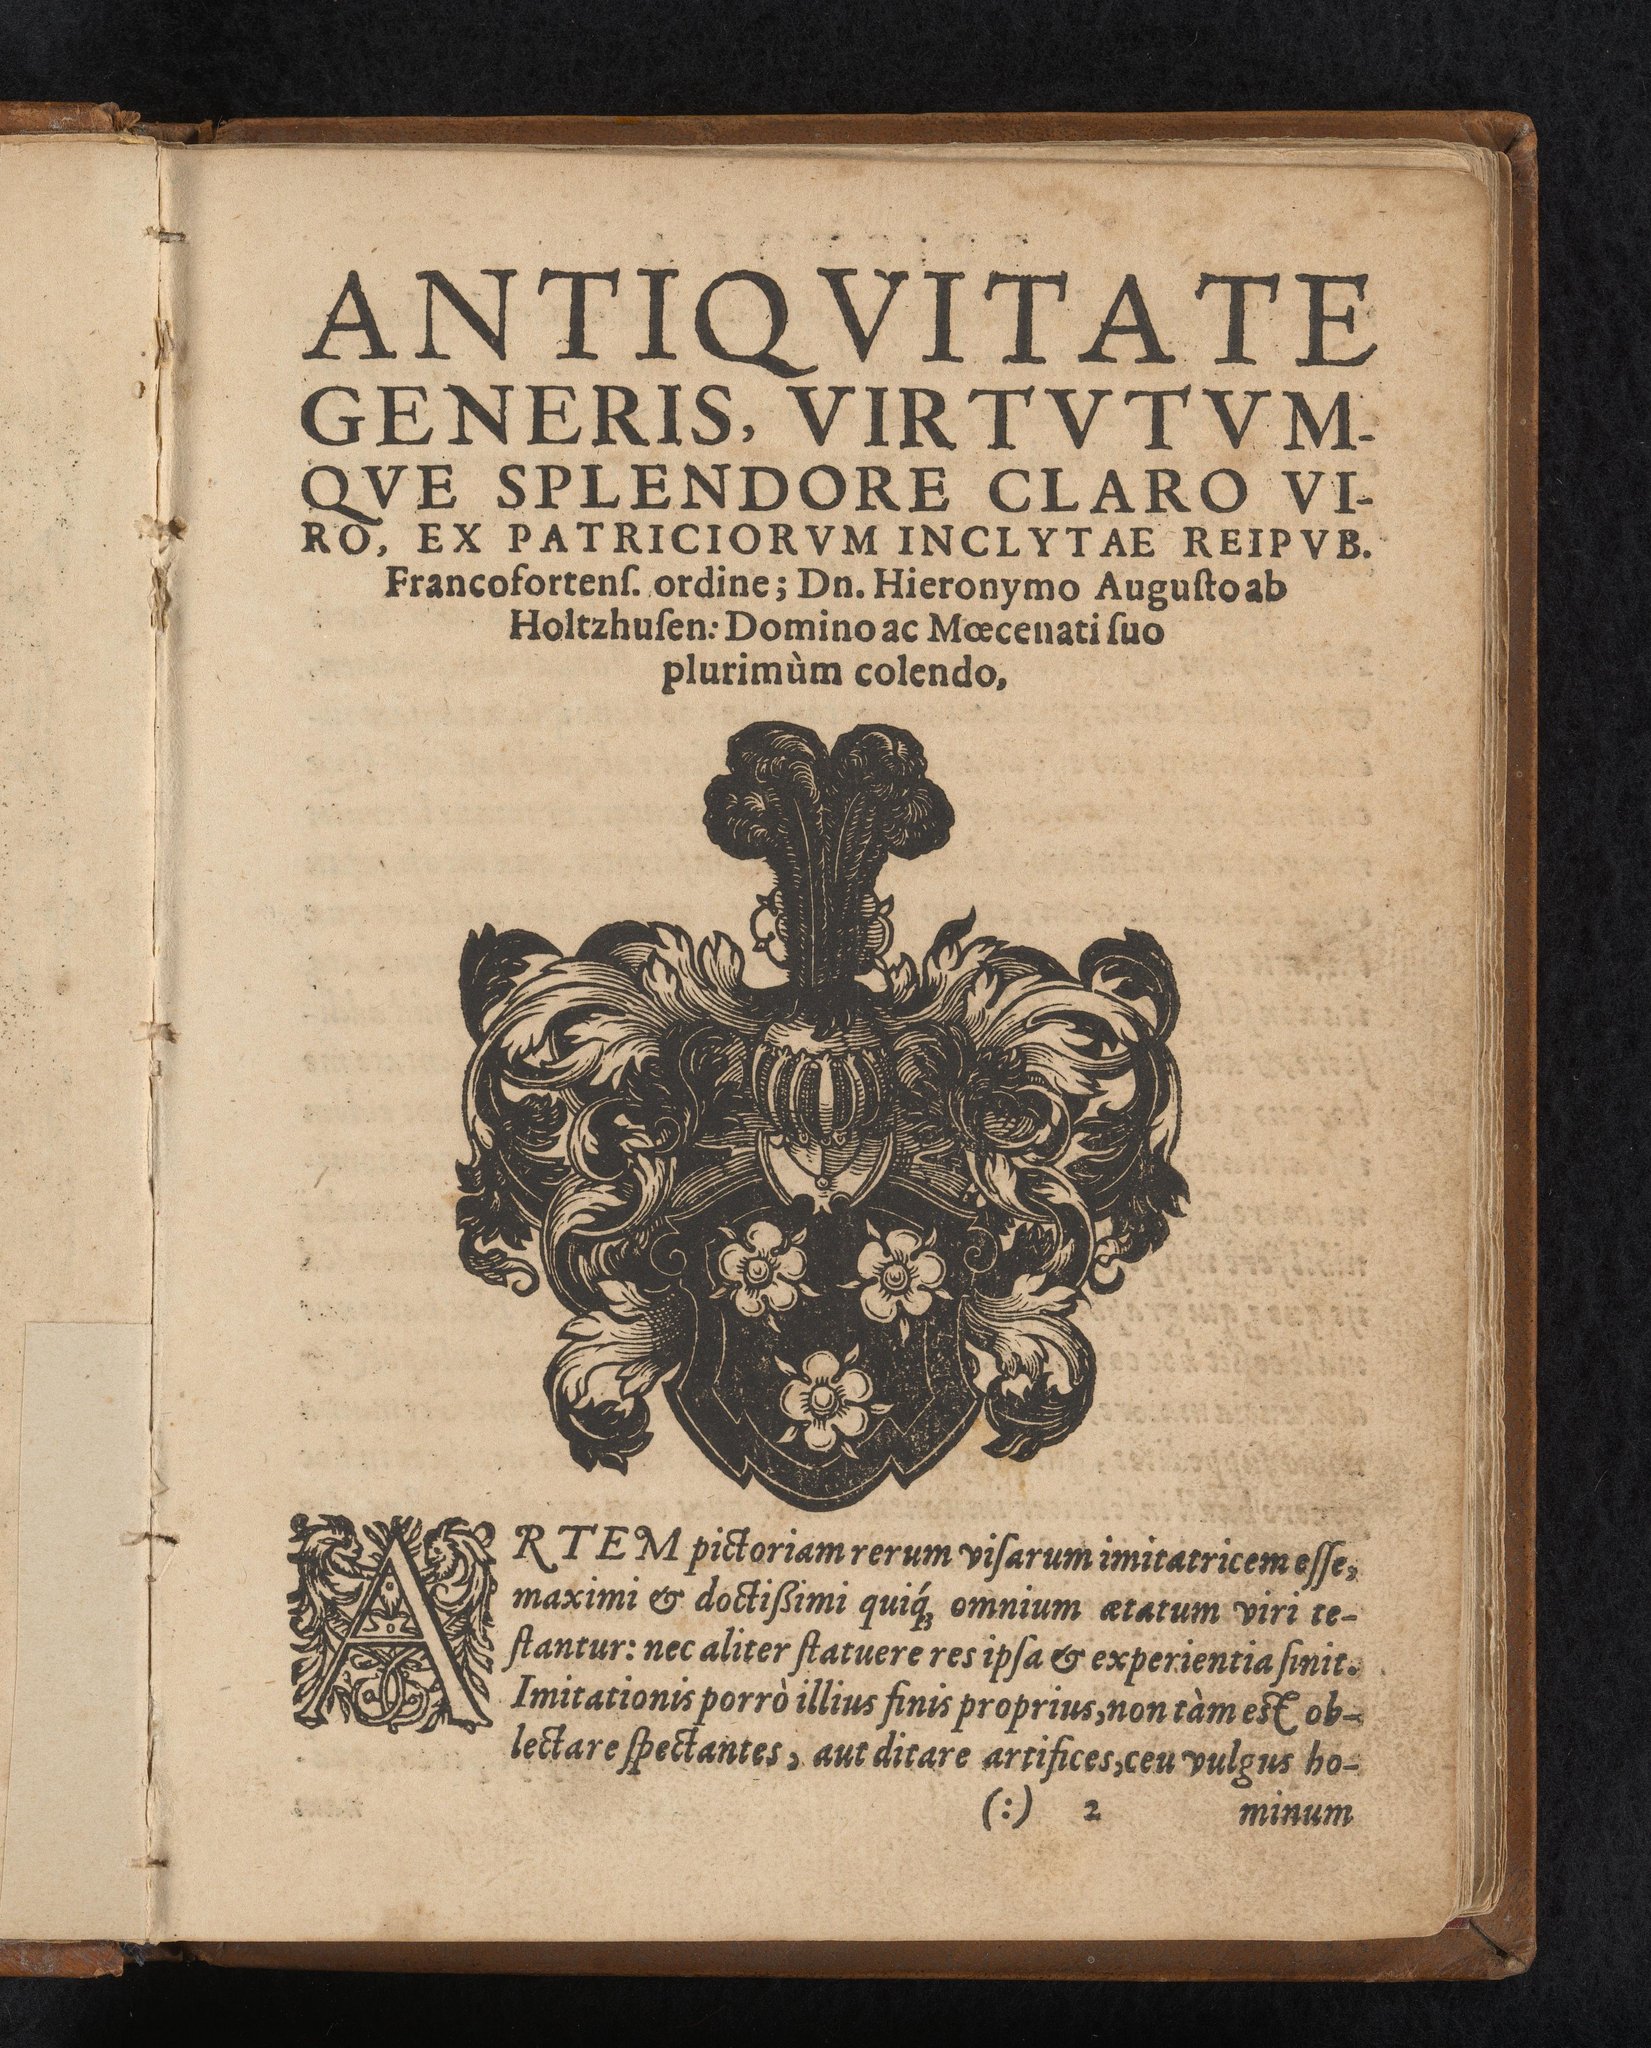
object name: titelblad, titelpagina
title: Beginpagina met tekst en wapen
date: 1578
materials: paper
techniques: letterpress printing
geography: nuremberg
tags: armorial bearing, heraldry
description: Beginpagina met een Latijnse tekst 'Antiquitate generis' en het wapen van de Frankfurter patriciërsfamilie Holzhausen. Onderdeel van het modelboek Enchiridion artis pingendi, fingendi & sculpendi met 108 figuren bedoeld voor beginnende schilders, beeldhouwers en prentmakers.